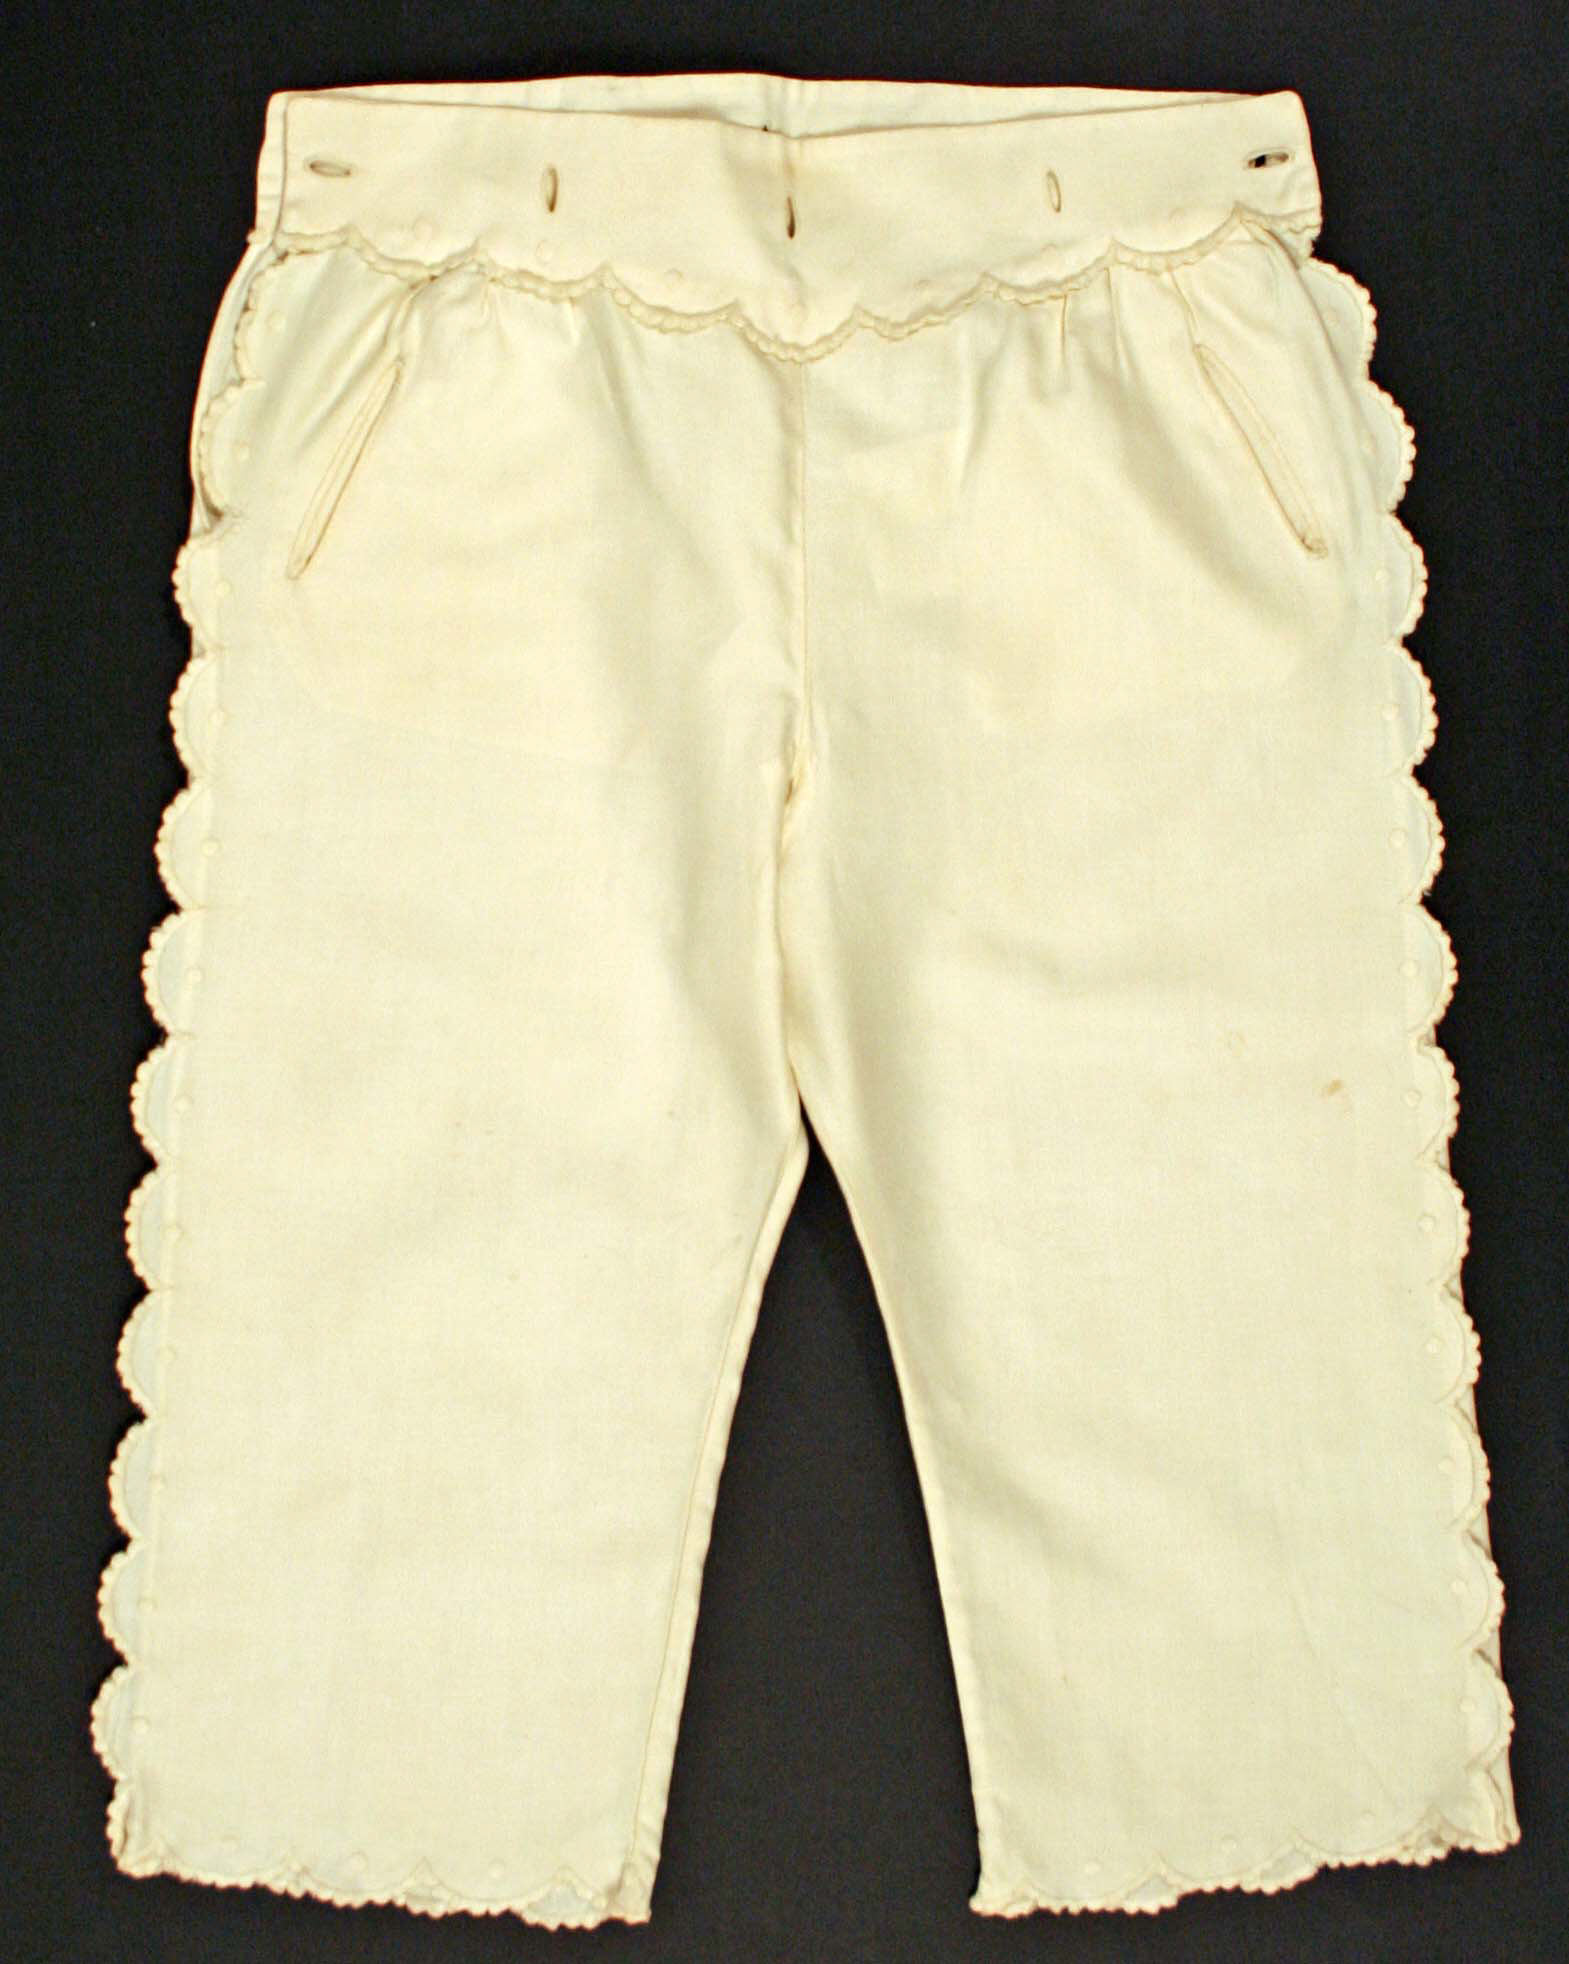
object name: pantaloon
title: Pantaloons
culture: american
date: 1866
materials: cotton